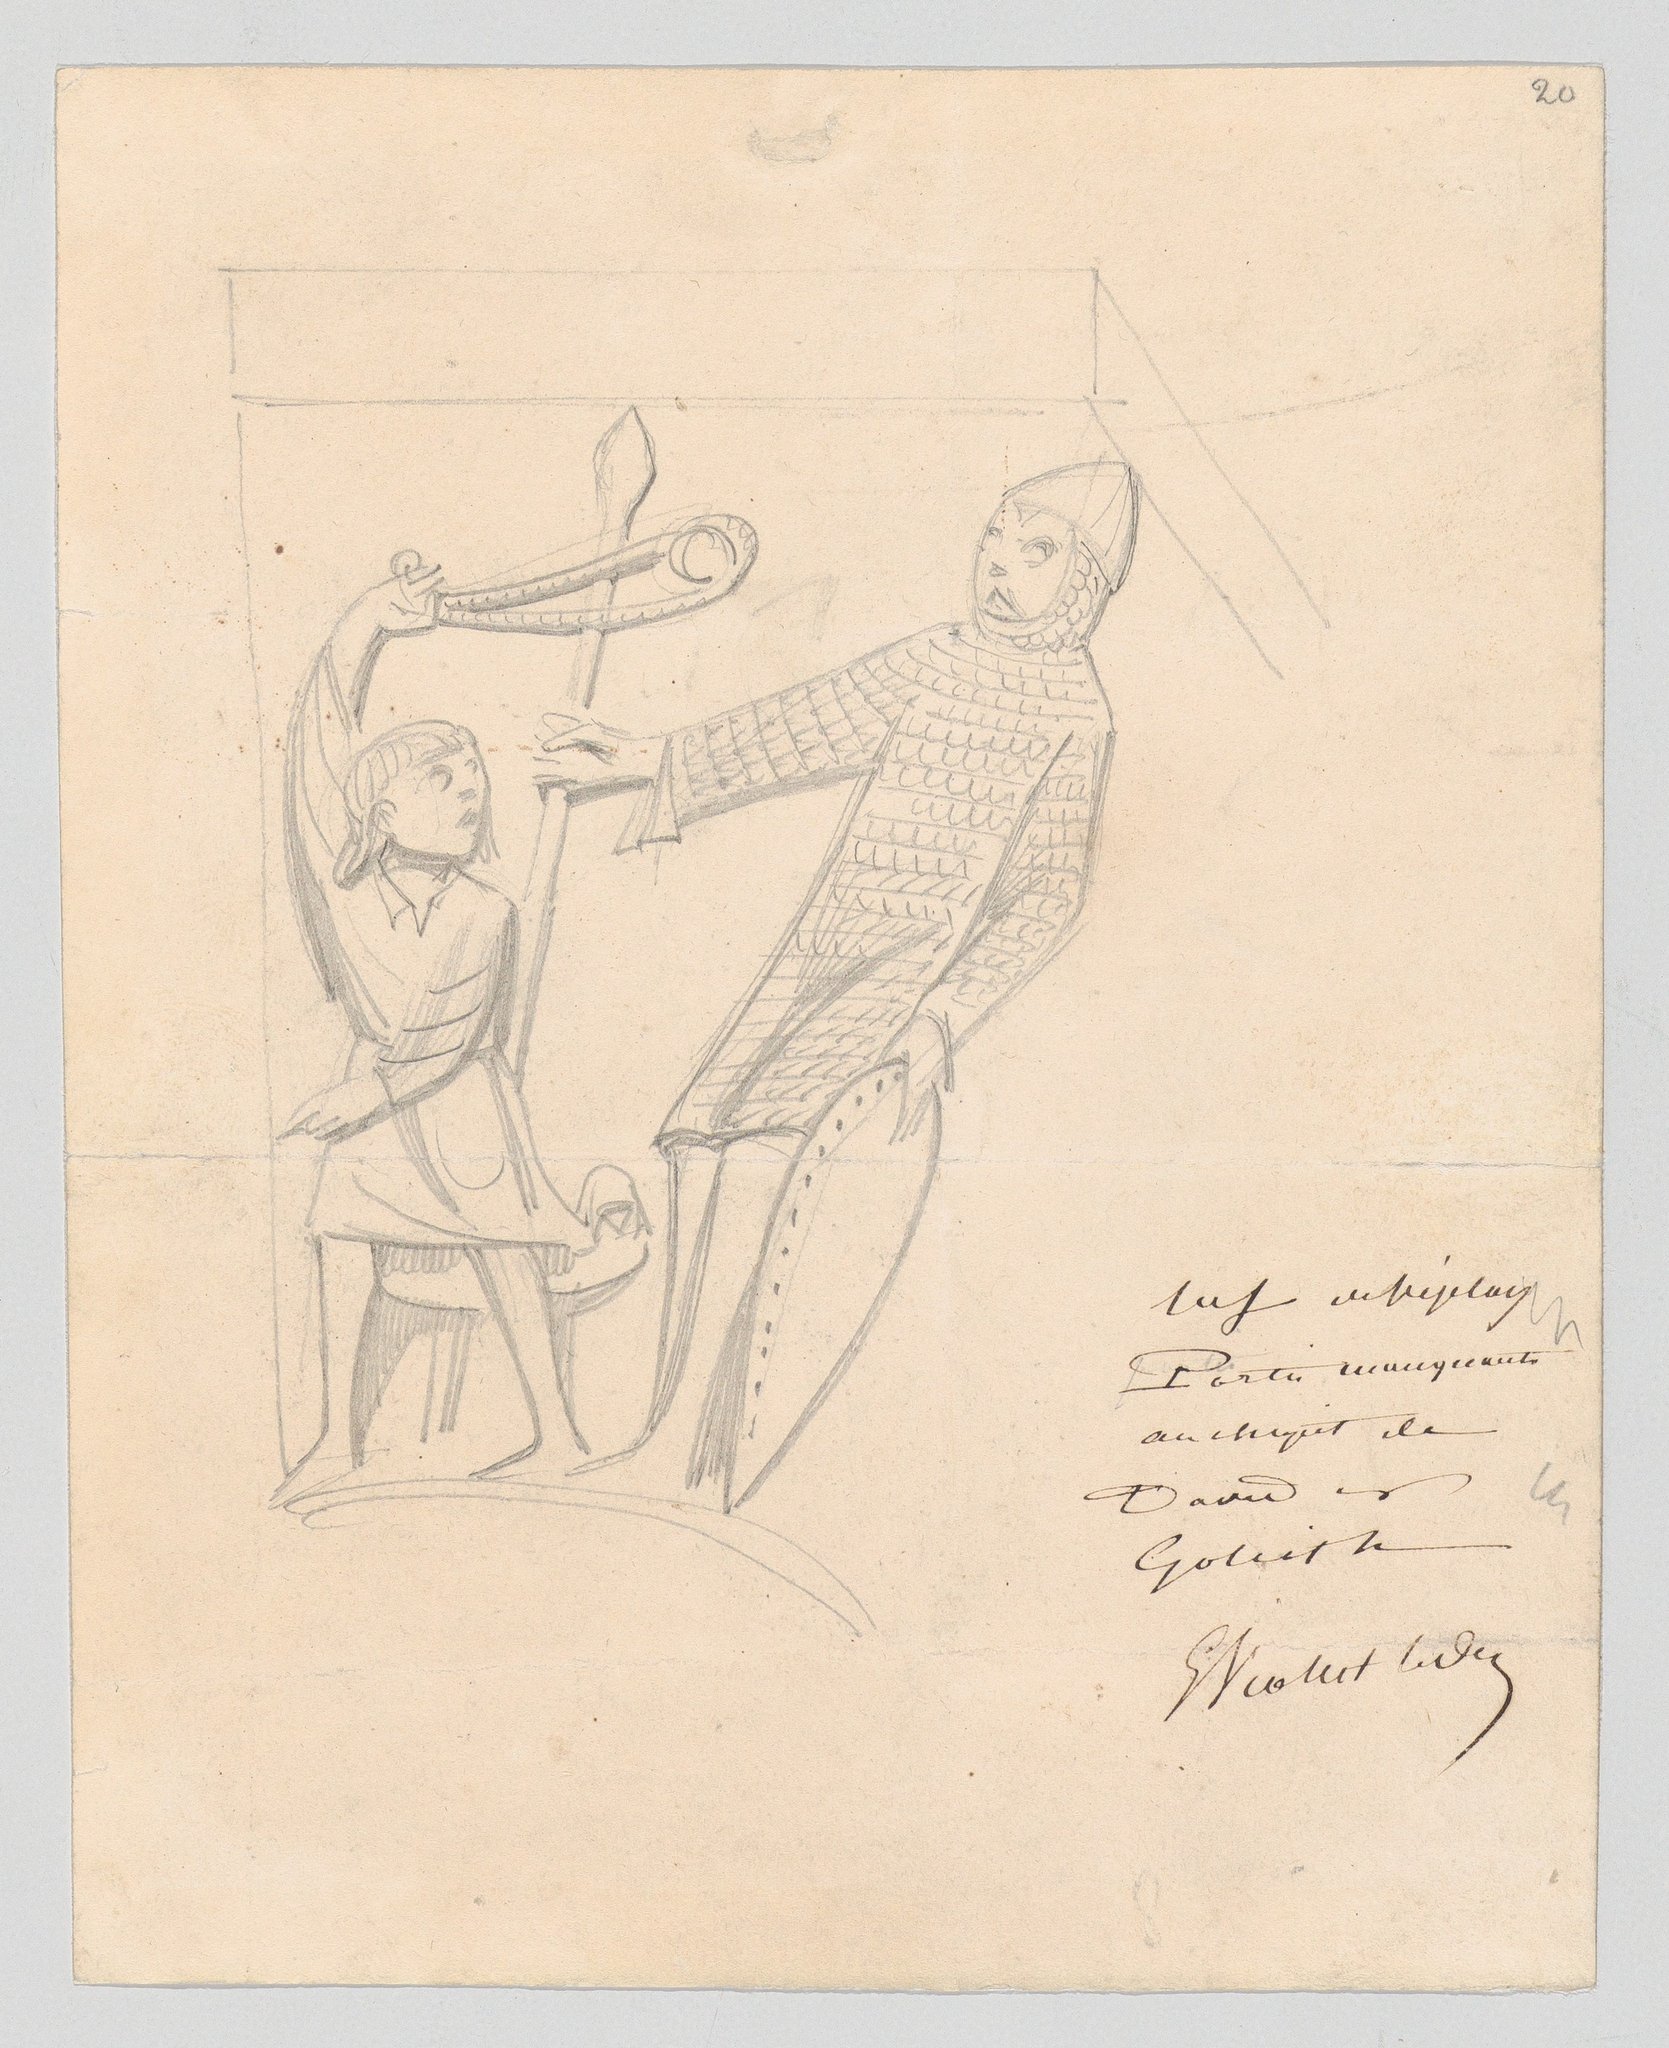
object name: drawing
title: David and Goliath, after a Capital in Vézelay Abbey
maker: eugène-emmanuel viollet-le-duc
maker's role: artist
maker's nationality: french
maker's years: 1814-1879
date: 1840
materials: graphite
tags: soldiers,weapons,david